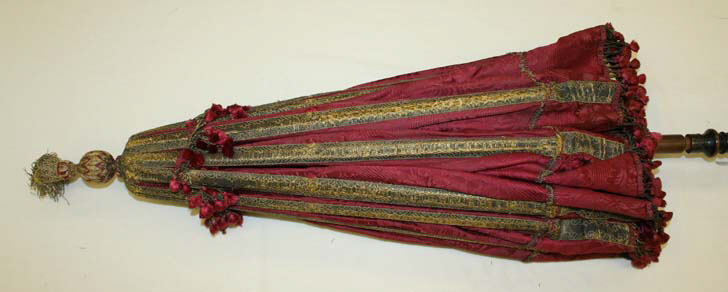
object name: parasol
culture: french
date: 1675-1725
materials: silk